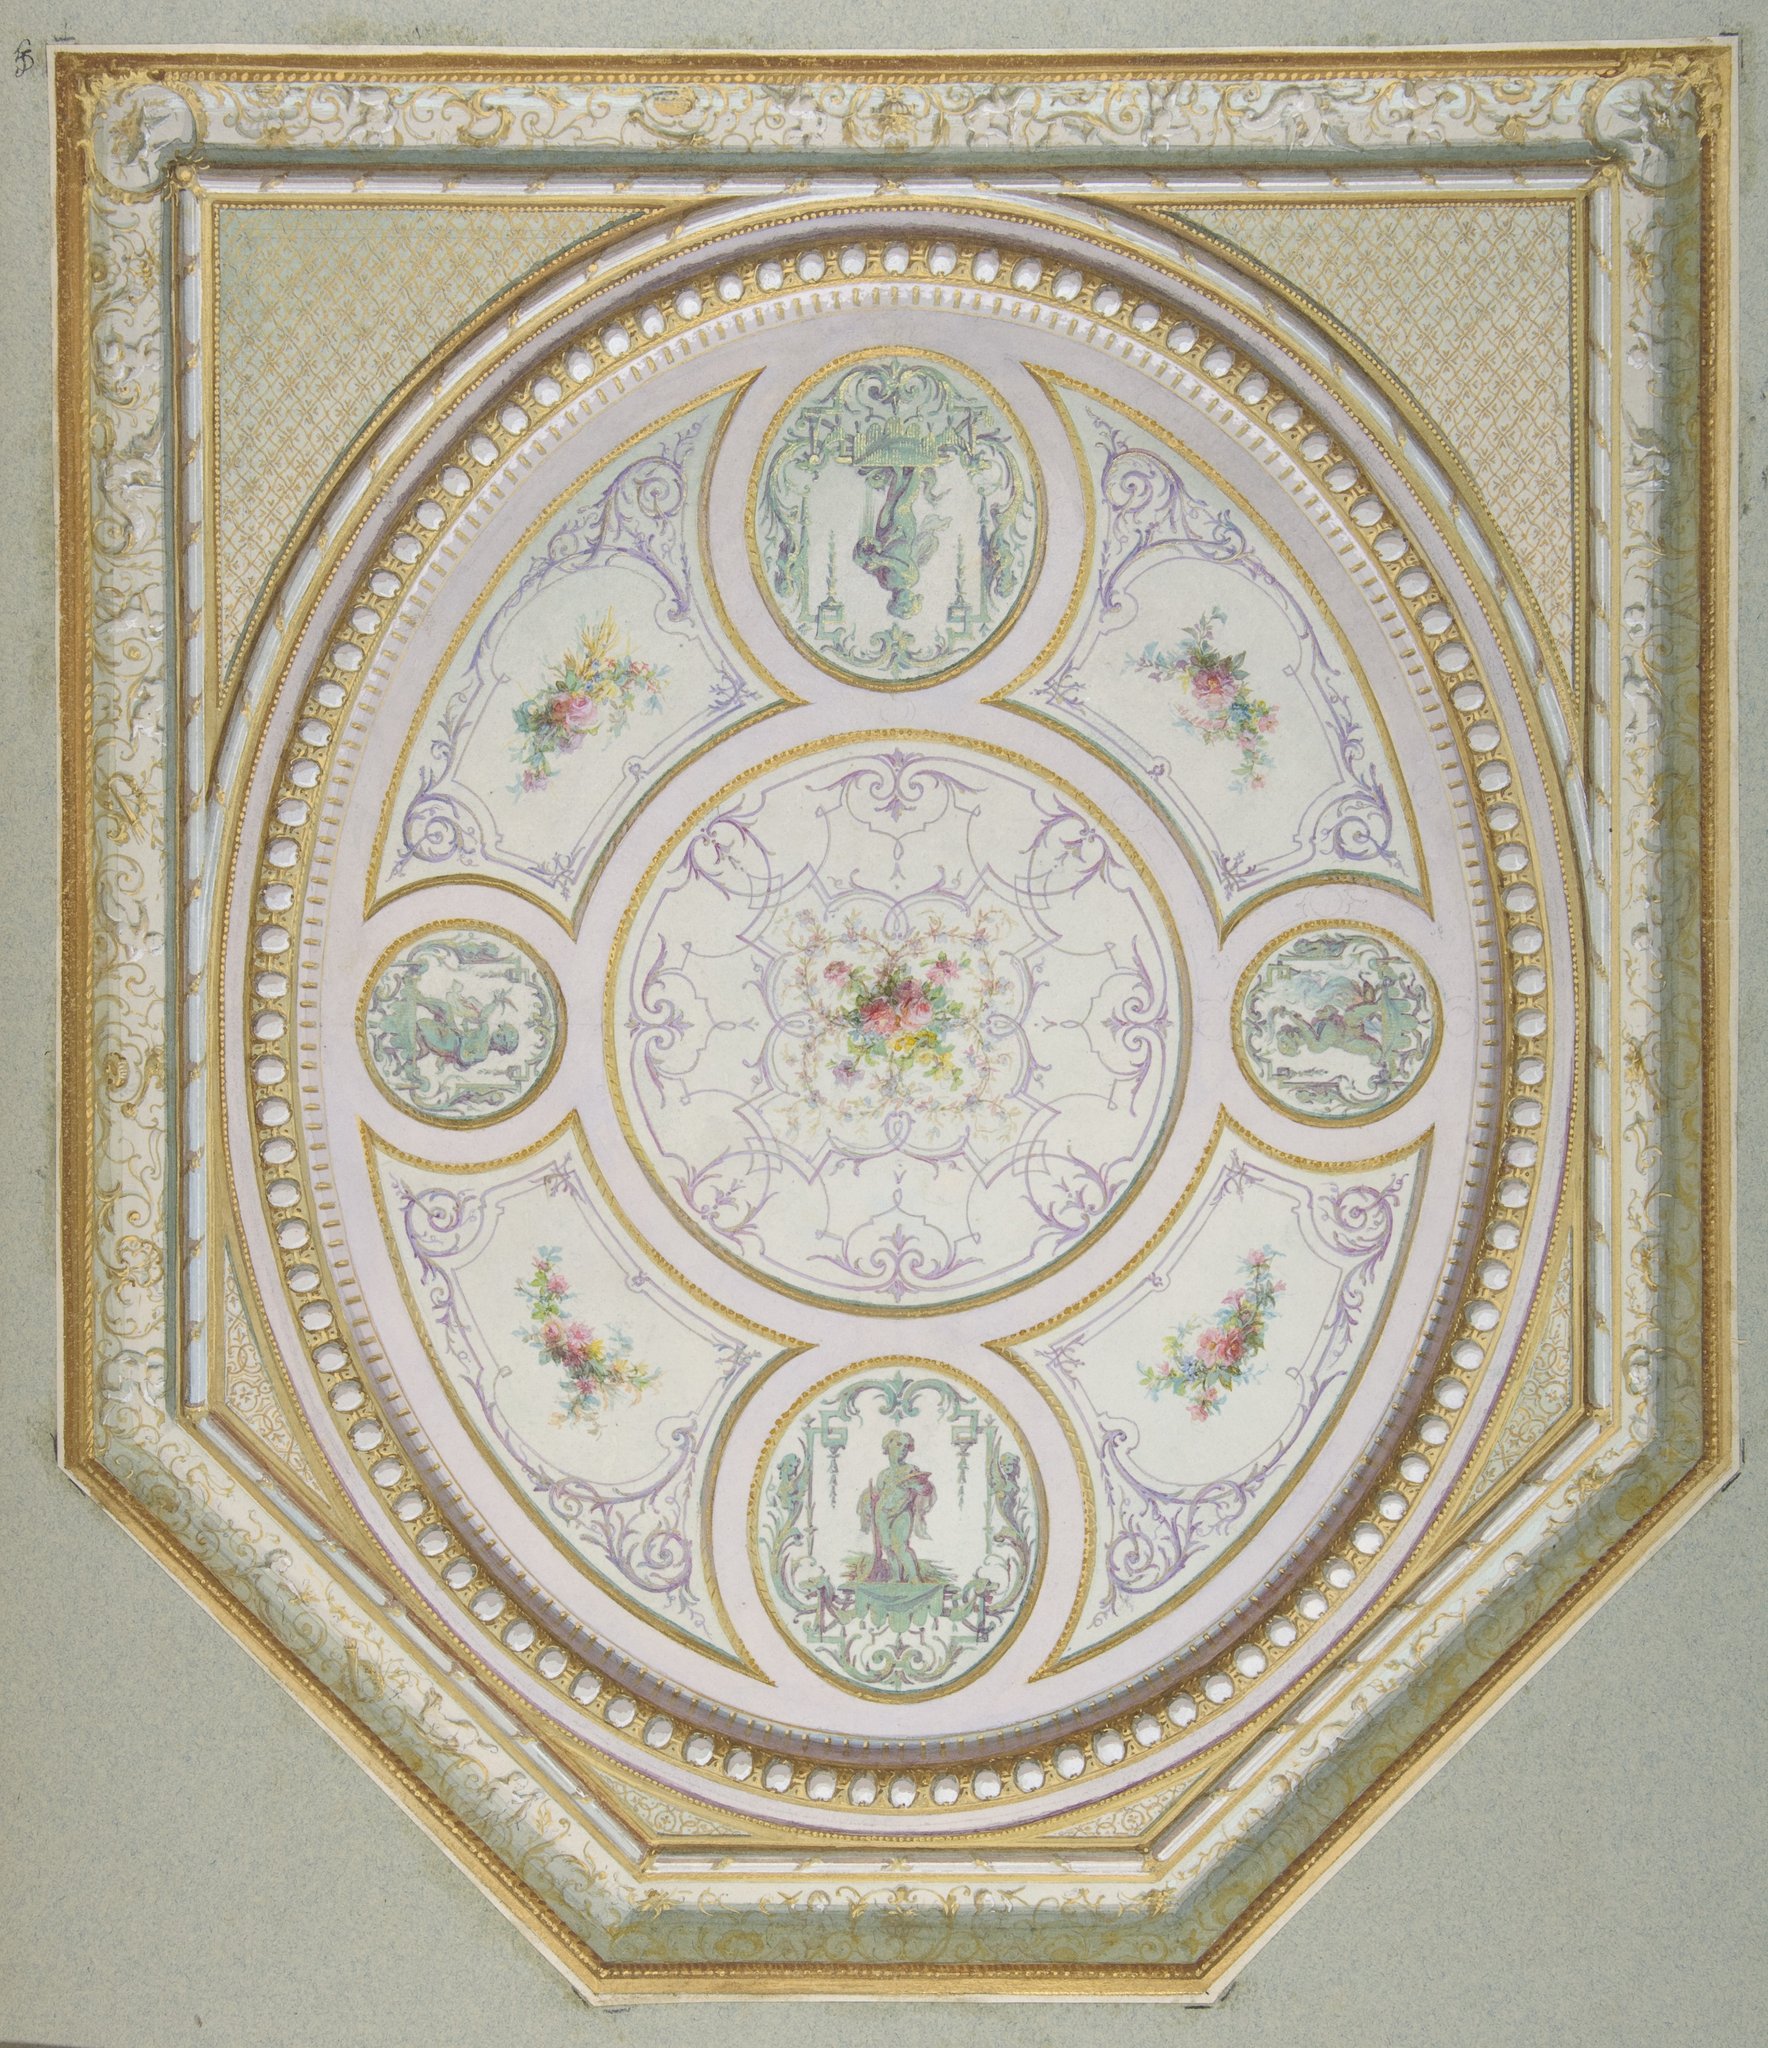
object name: drawing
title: Ceiling Design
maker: jules-edmond-charles lachaise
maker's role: artist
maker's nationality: french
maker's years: 1897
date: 1851-1900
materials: gilt, gouache, graphite, watercolor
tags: human figures,flowers